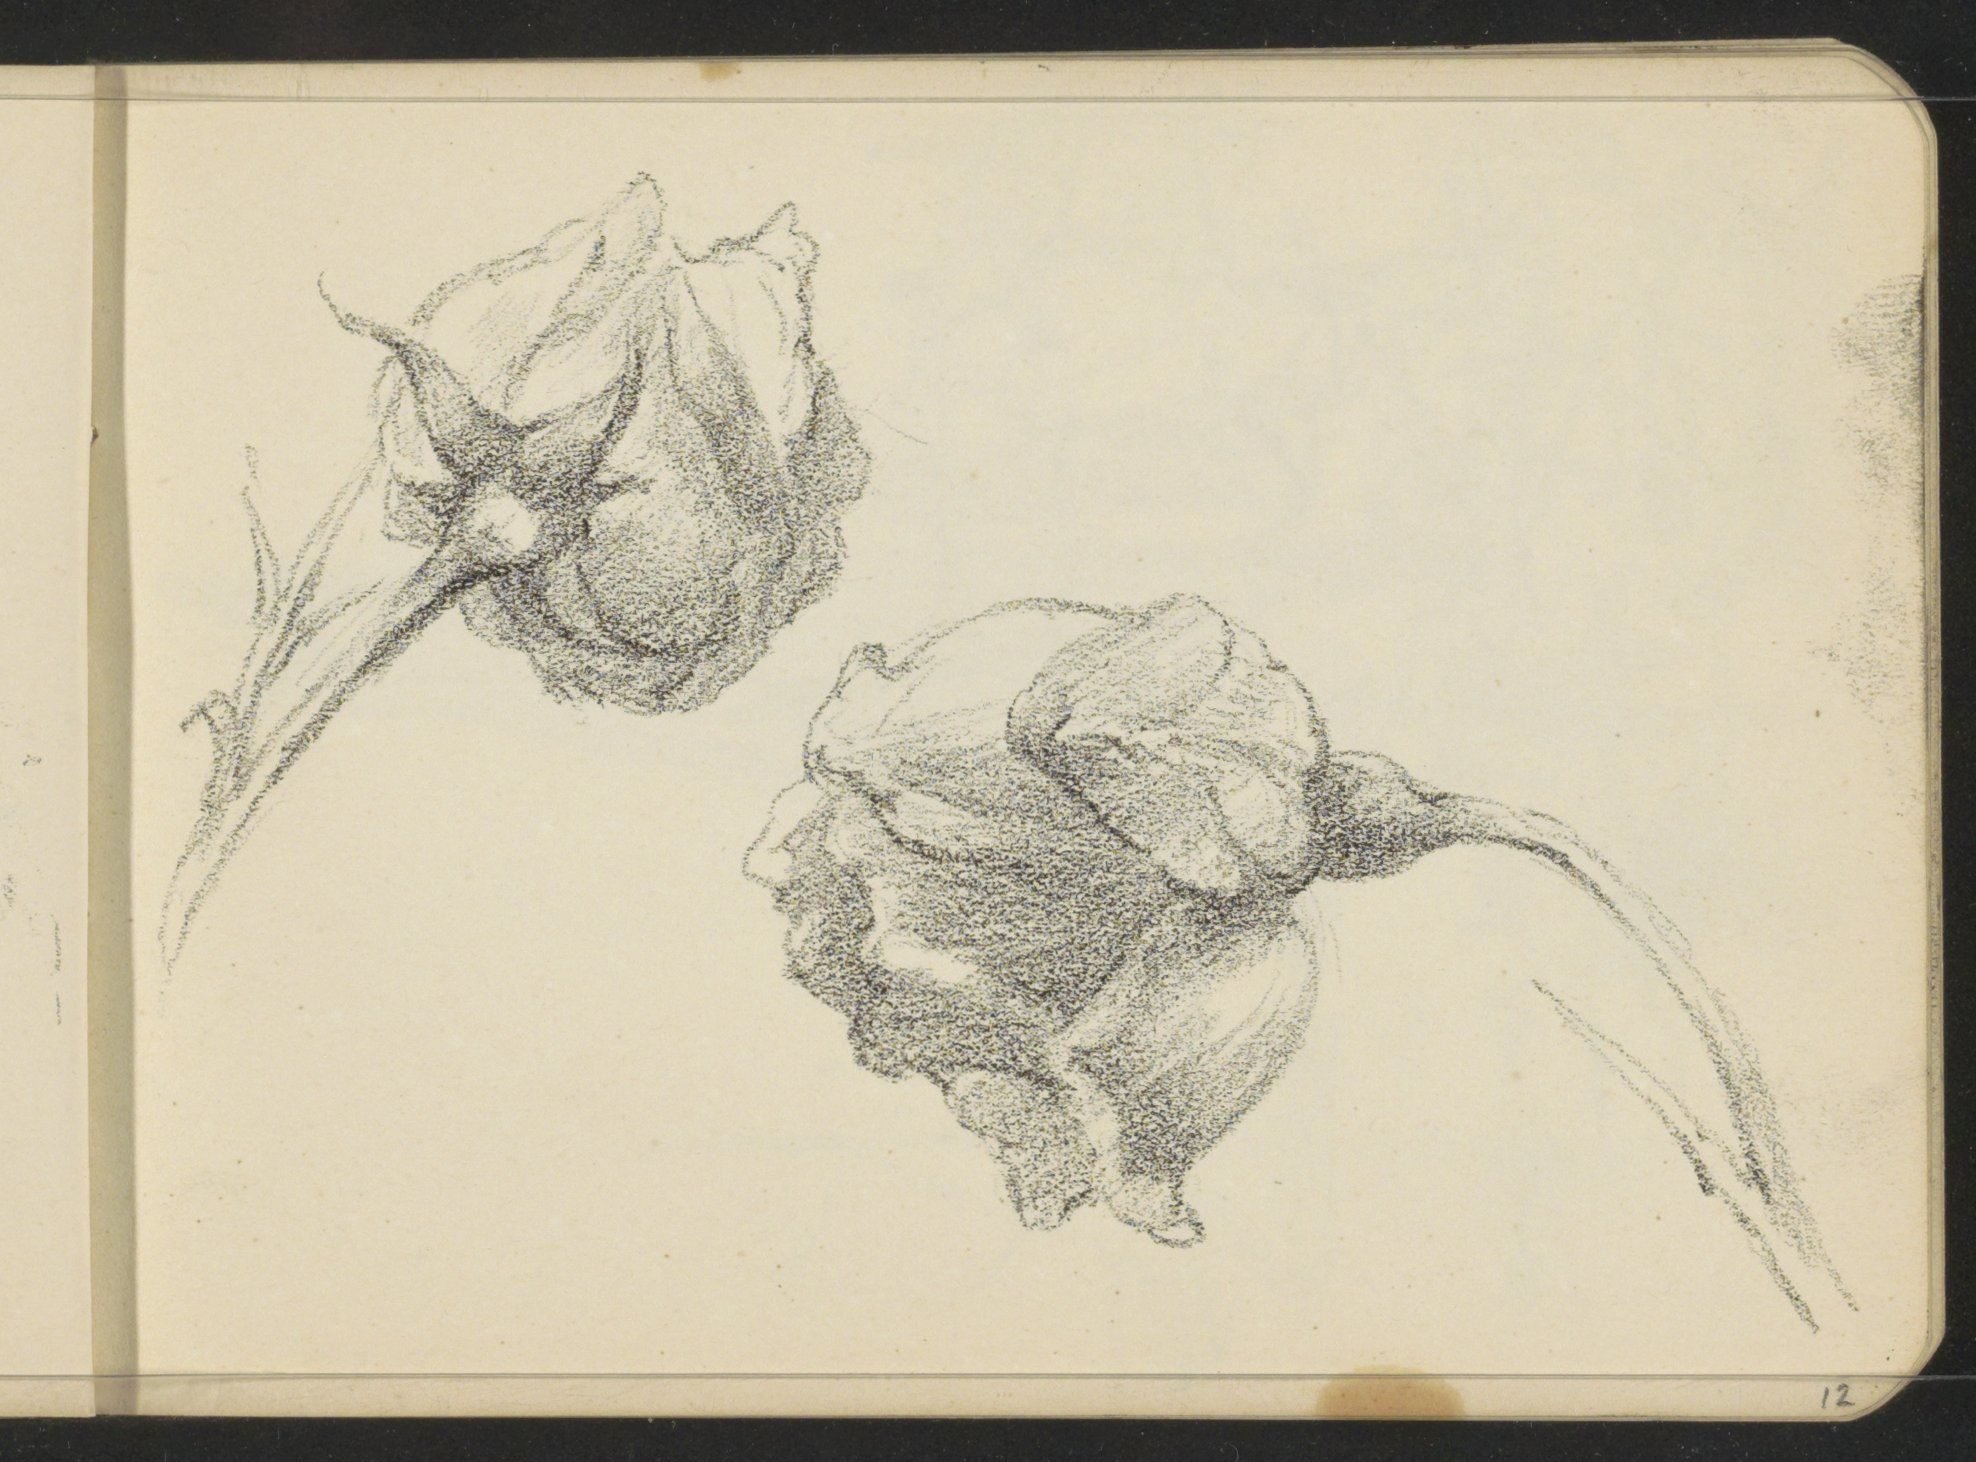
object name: sketchbook leaf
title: Twee rozen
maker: willem cornelis rip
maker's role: draughtsman, painter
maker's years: 1856-1922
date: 1914-1916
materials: chalk, paper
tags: flowers: rose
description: Blad 12 recto uit een schetsboek met 41 bladen.